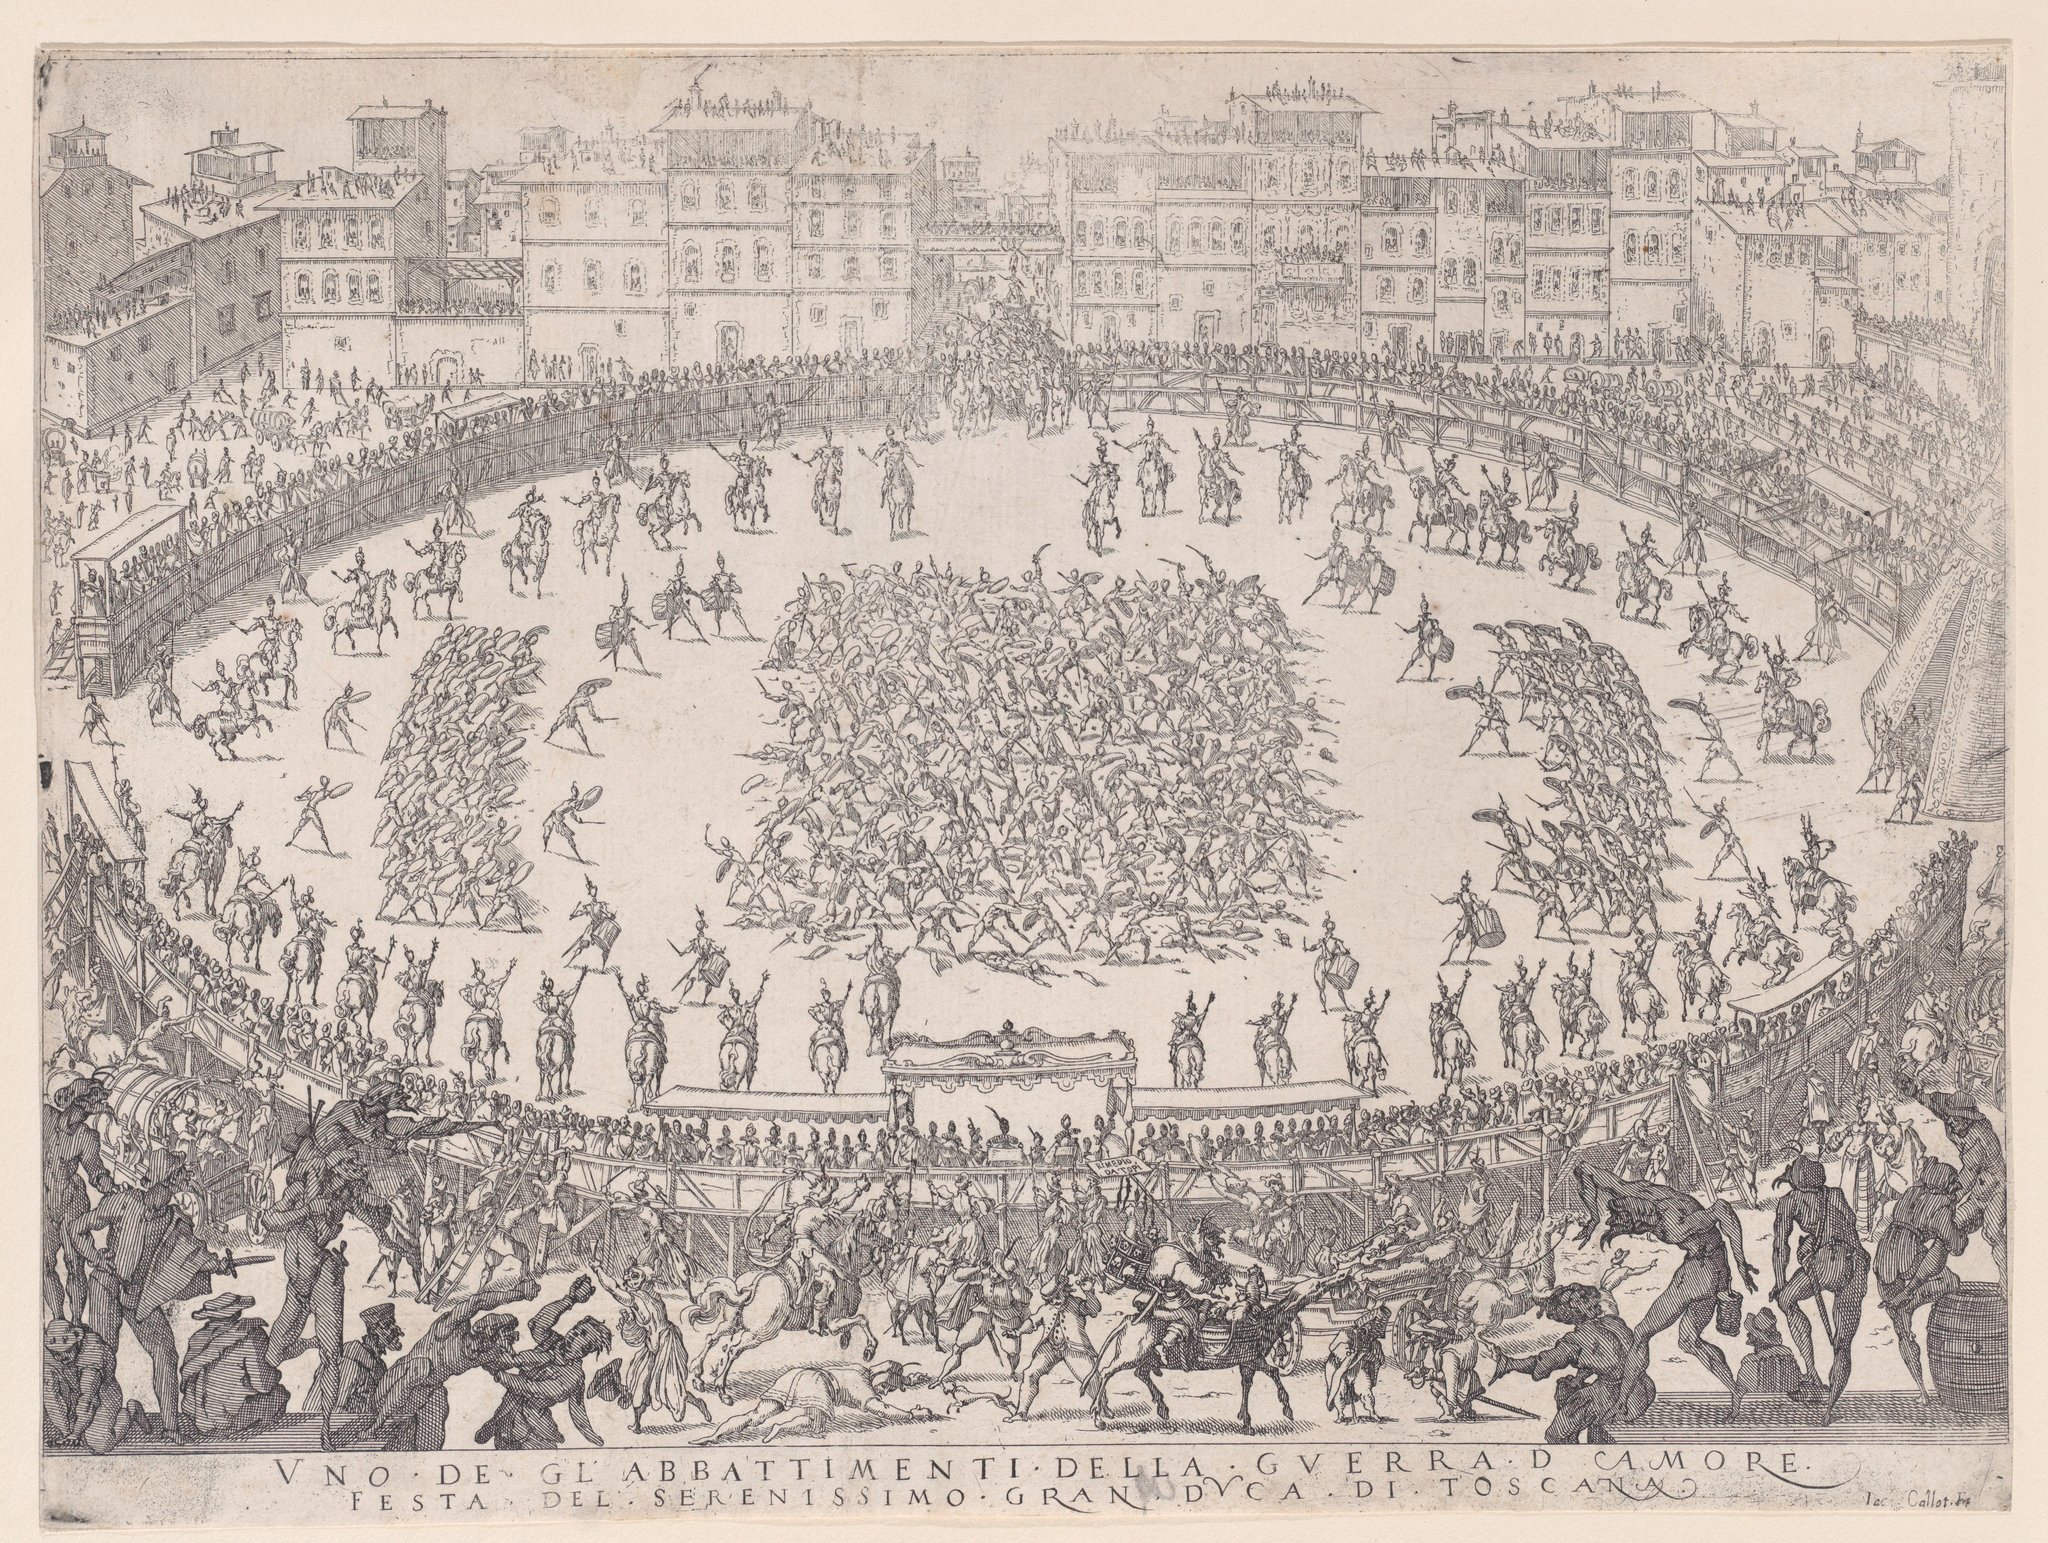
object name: print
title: Le Combat des Sections d'Infantrie (The Battle of the Sections of Infantry), from "La Guerre d'Amour" (Guerra d'Amore) (War of Love)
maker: jacques callot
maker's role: artist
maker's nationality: french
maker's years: 1592-1635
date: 1615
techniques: etching